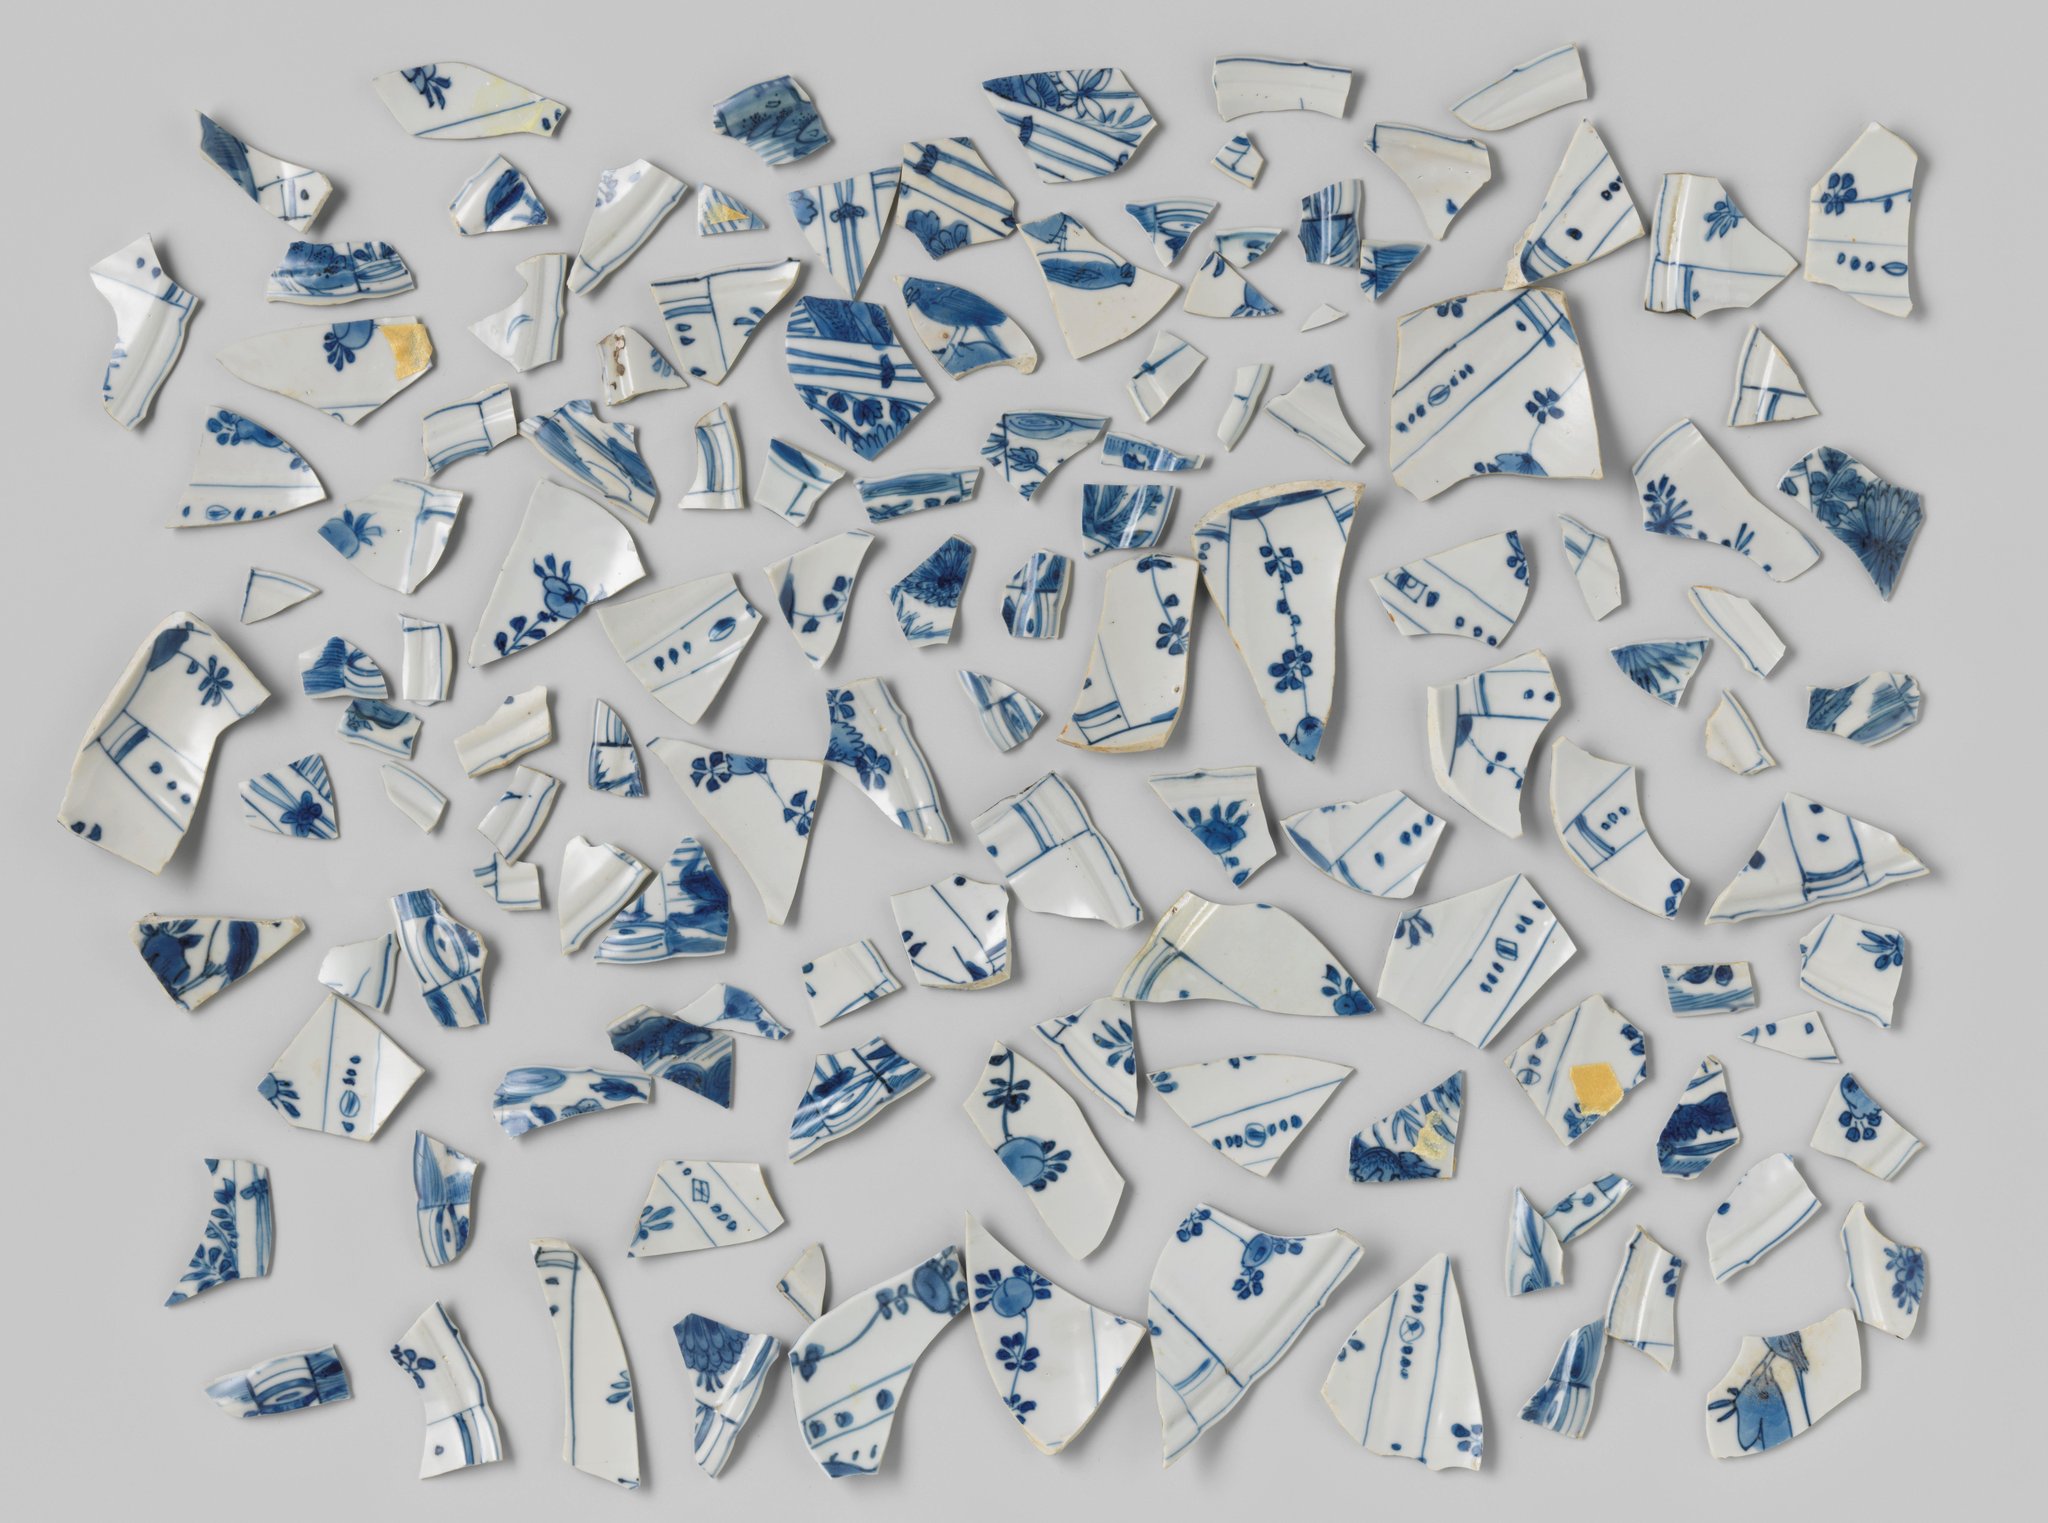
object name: bowl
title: Scherven van kraaikoppen uit V.O.C.-schip de 'Witte Leeuw'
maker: Anonymous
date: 1613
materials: bone china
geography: jingdezhen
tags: verenigde oostindische compagnie, sint-helena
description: Scherven van kraaikoppen uit V.O.C.-schip de 'Witte Leeuw'.